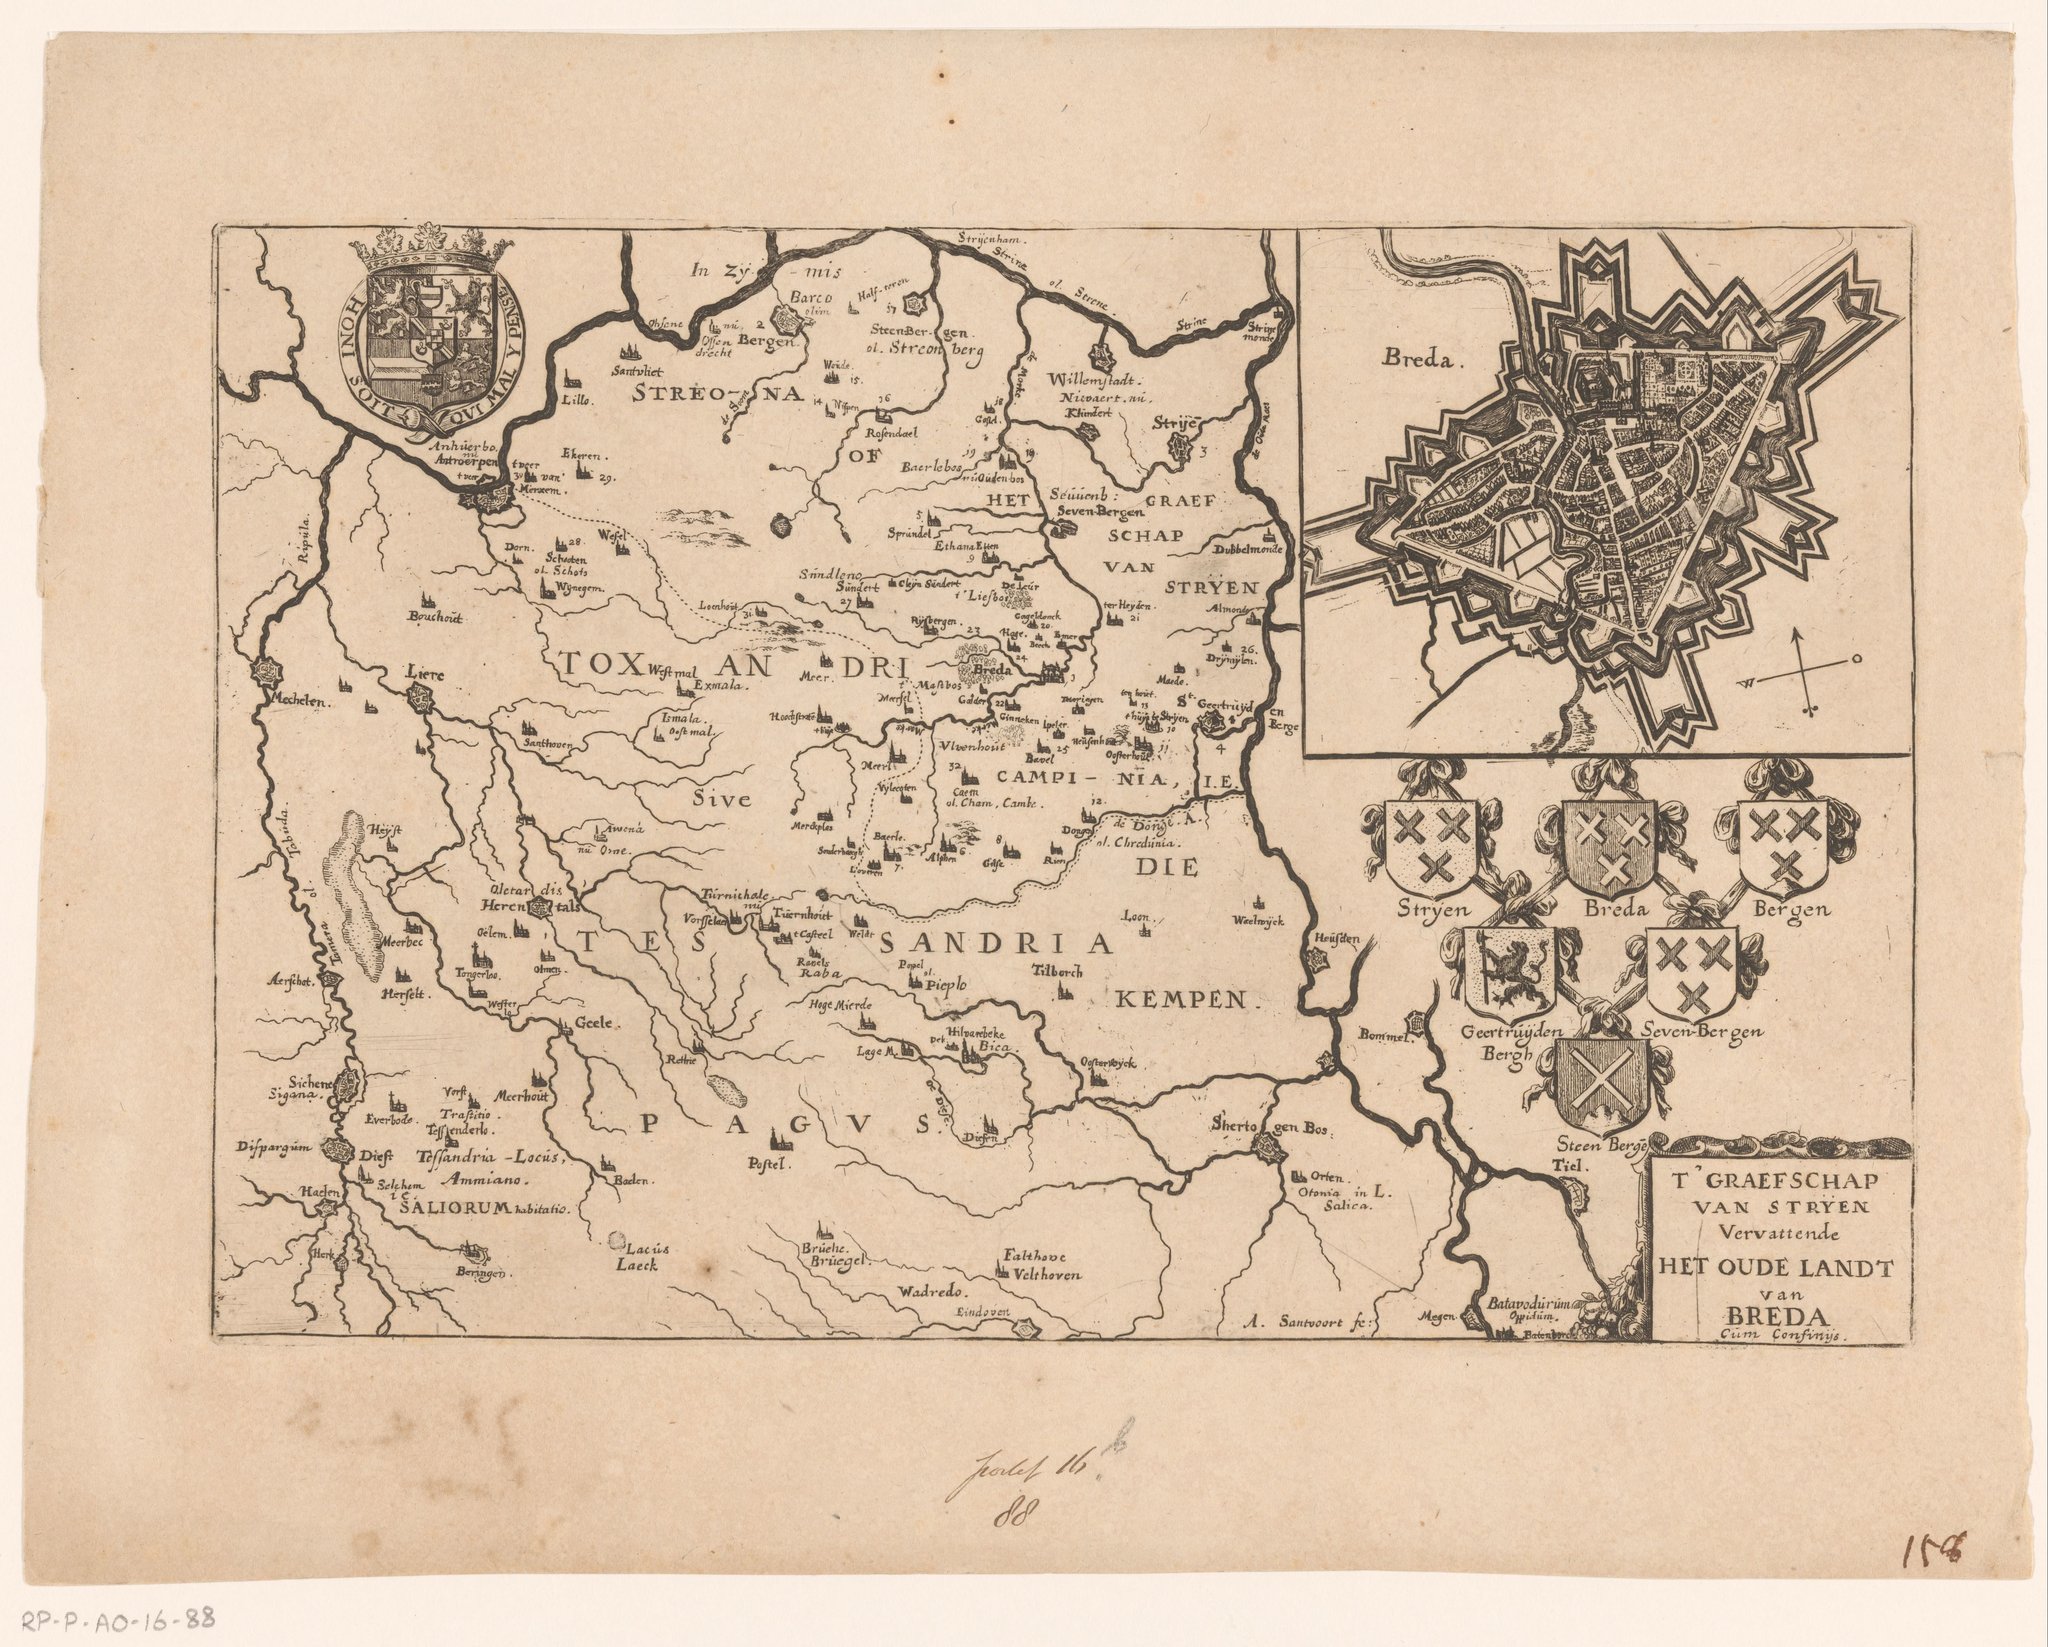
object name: area plan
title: T' Graefschap van Stryen vervattende het oude landt van Breda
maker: abraham dircksz. santvoort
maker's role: print maker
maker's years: 1614-1669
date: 1663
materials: paper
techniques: engraving, etching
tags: delft, the hague, frederick henry (prince of orange), coat of arms (as symbol of the state, etc.) (+ city; municipal), maps of separate countries or regions, maps of cities, armorial bearing, heraldry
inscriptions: collector's mark: Lugt 2228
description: Kaart van het graafschap van Strijen en omliggende gebieden. Rechtsboven een inzet met plattegrond van Breda. Rechtsonder een cartouche met titel en zes wapenschilden van gemeentes op de kaart. Linksboven het wapen van Frederik Hendrik (prins van Oranje), waar omheen een band met de spreuk: "Honi soit qui mal y pense".